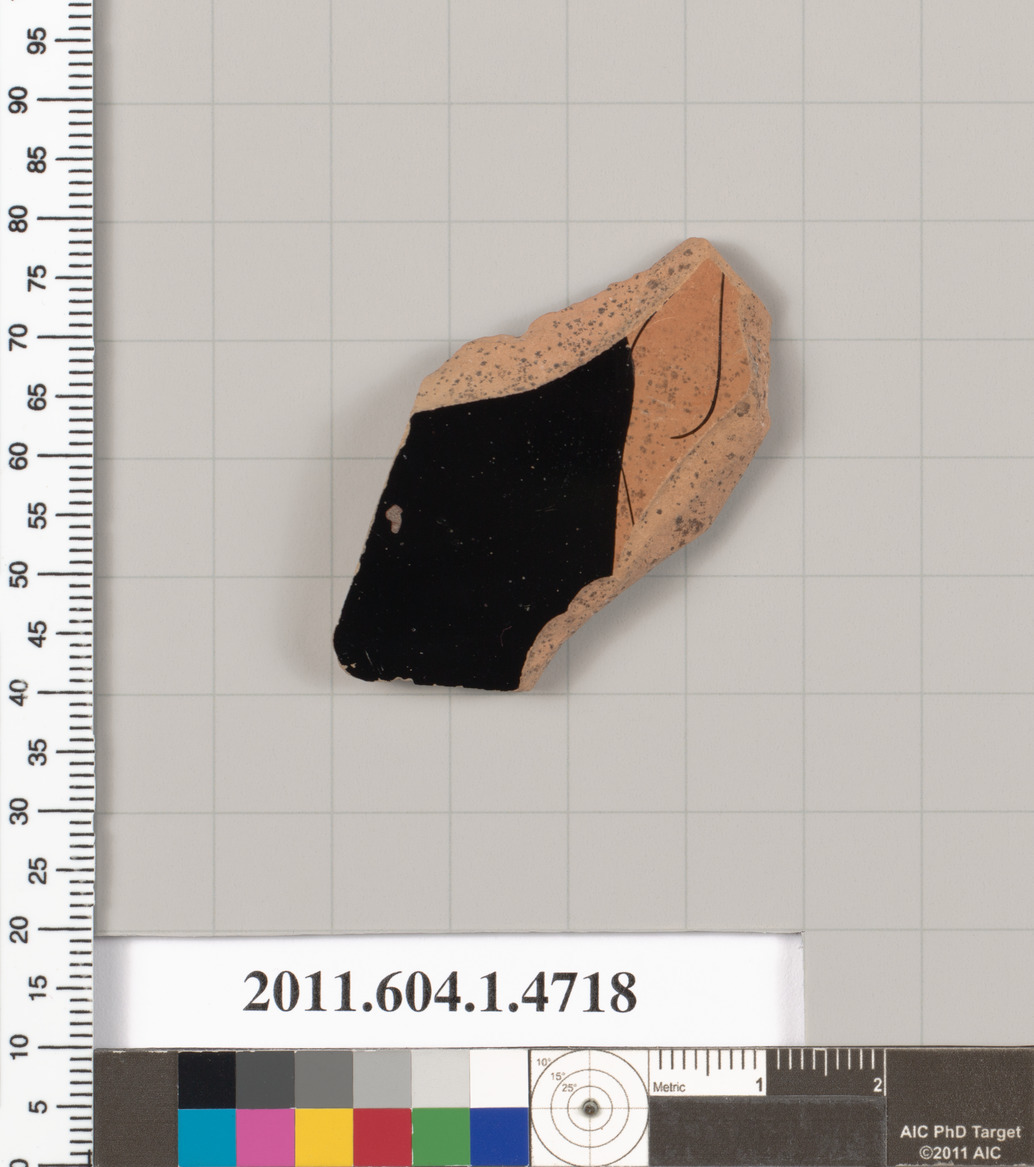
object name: kylix fragment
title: Terracotta fragment of a kylix (drinking cup)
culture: greek, attic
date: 475-451 BCE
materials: terracotta